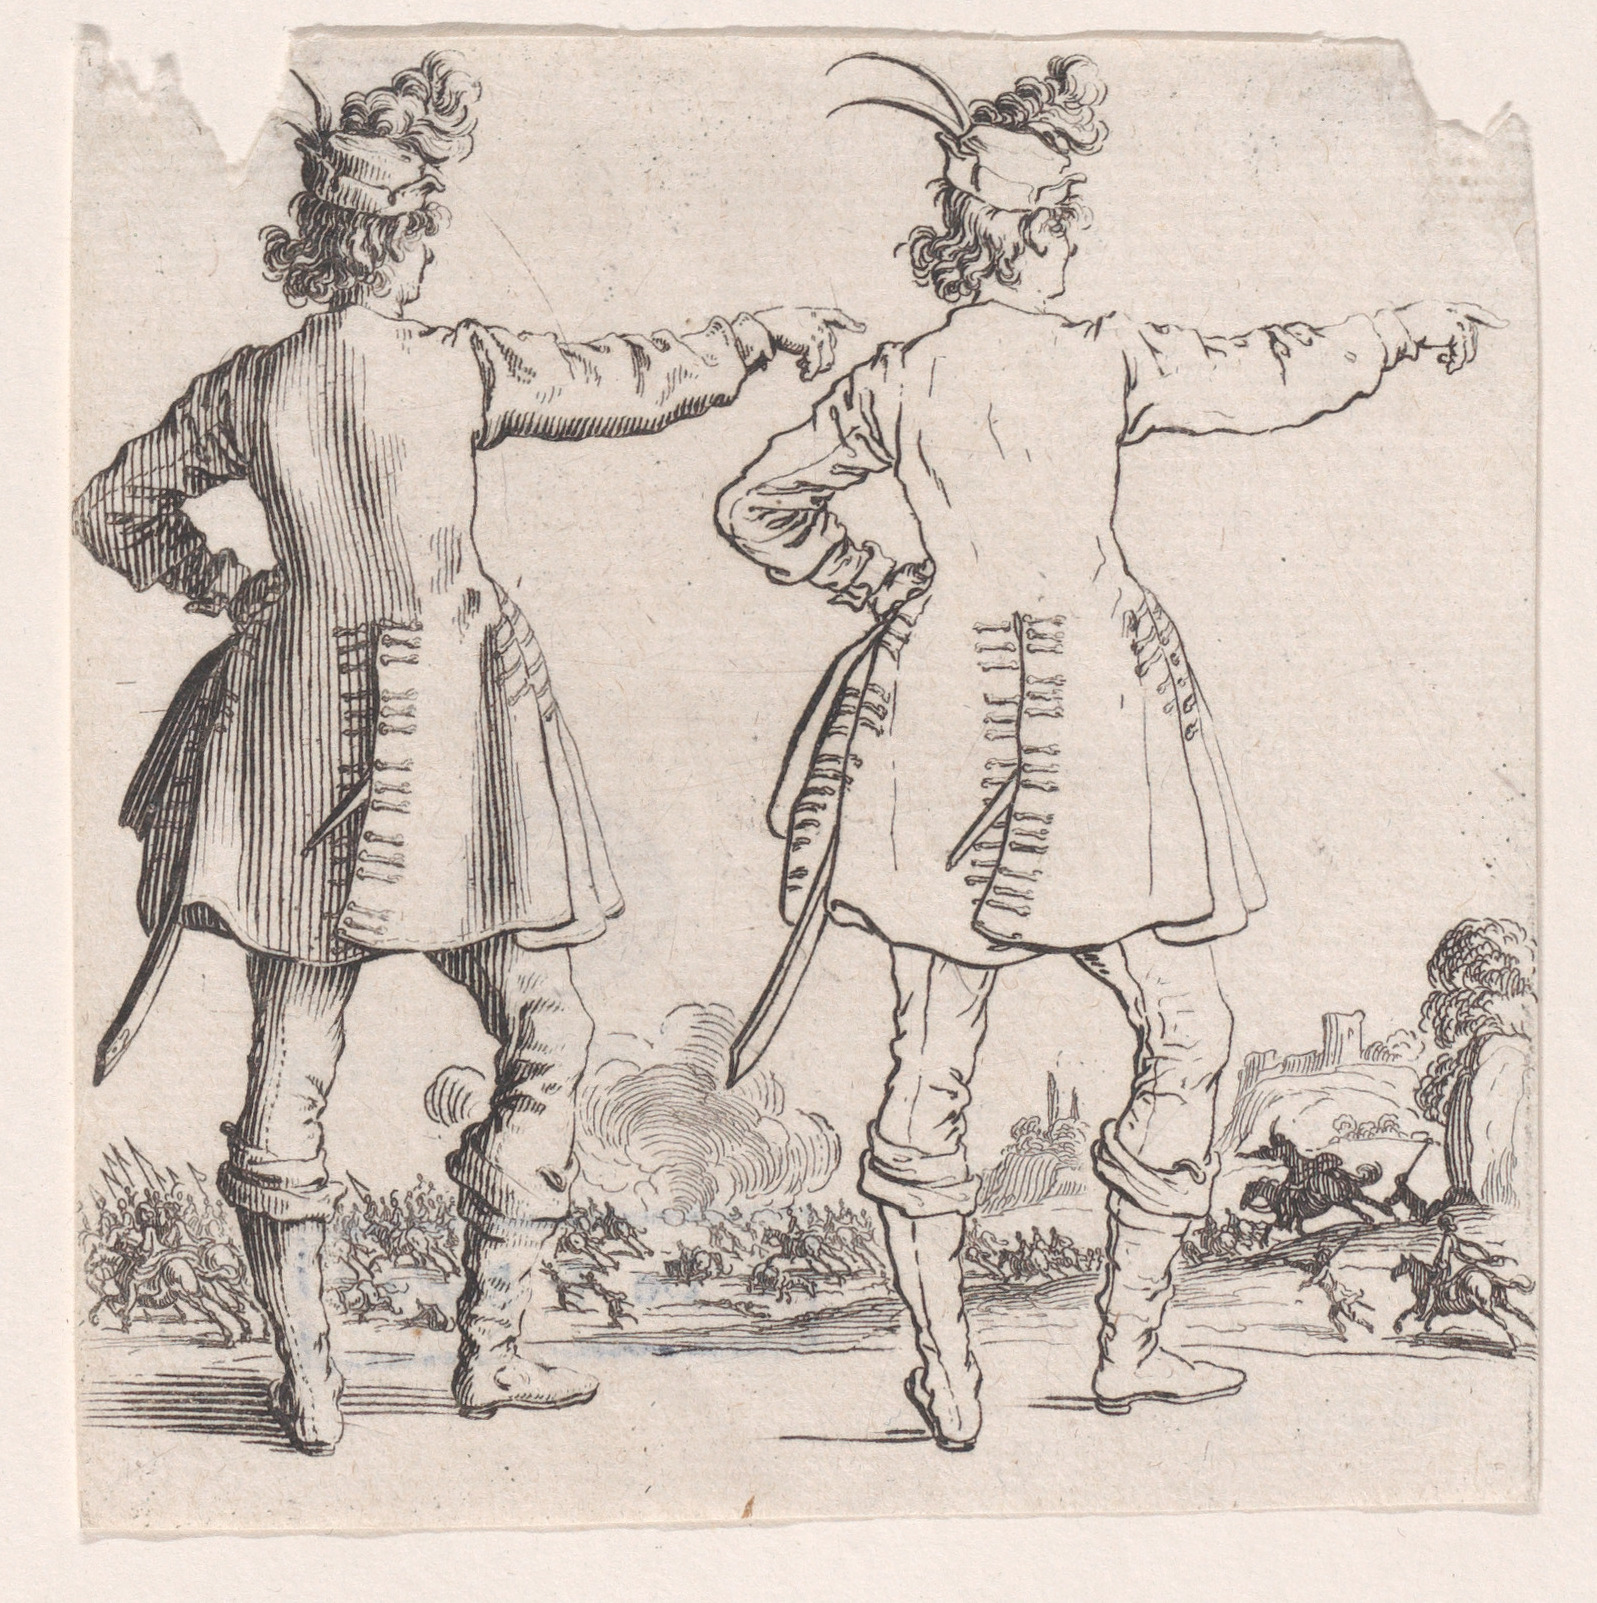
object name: print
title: Le Turc Vu de Dos (The Turk Seen from Behind), from "Varie Figure" (Various Figures)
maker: jacques callot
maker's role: artist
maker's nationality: french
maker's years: 1592-1635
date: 1620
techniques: etching